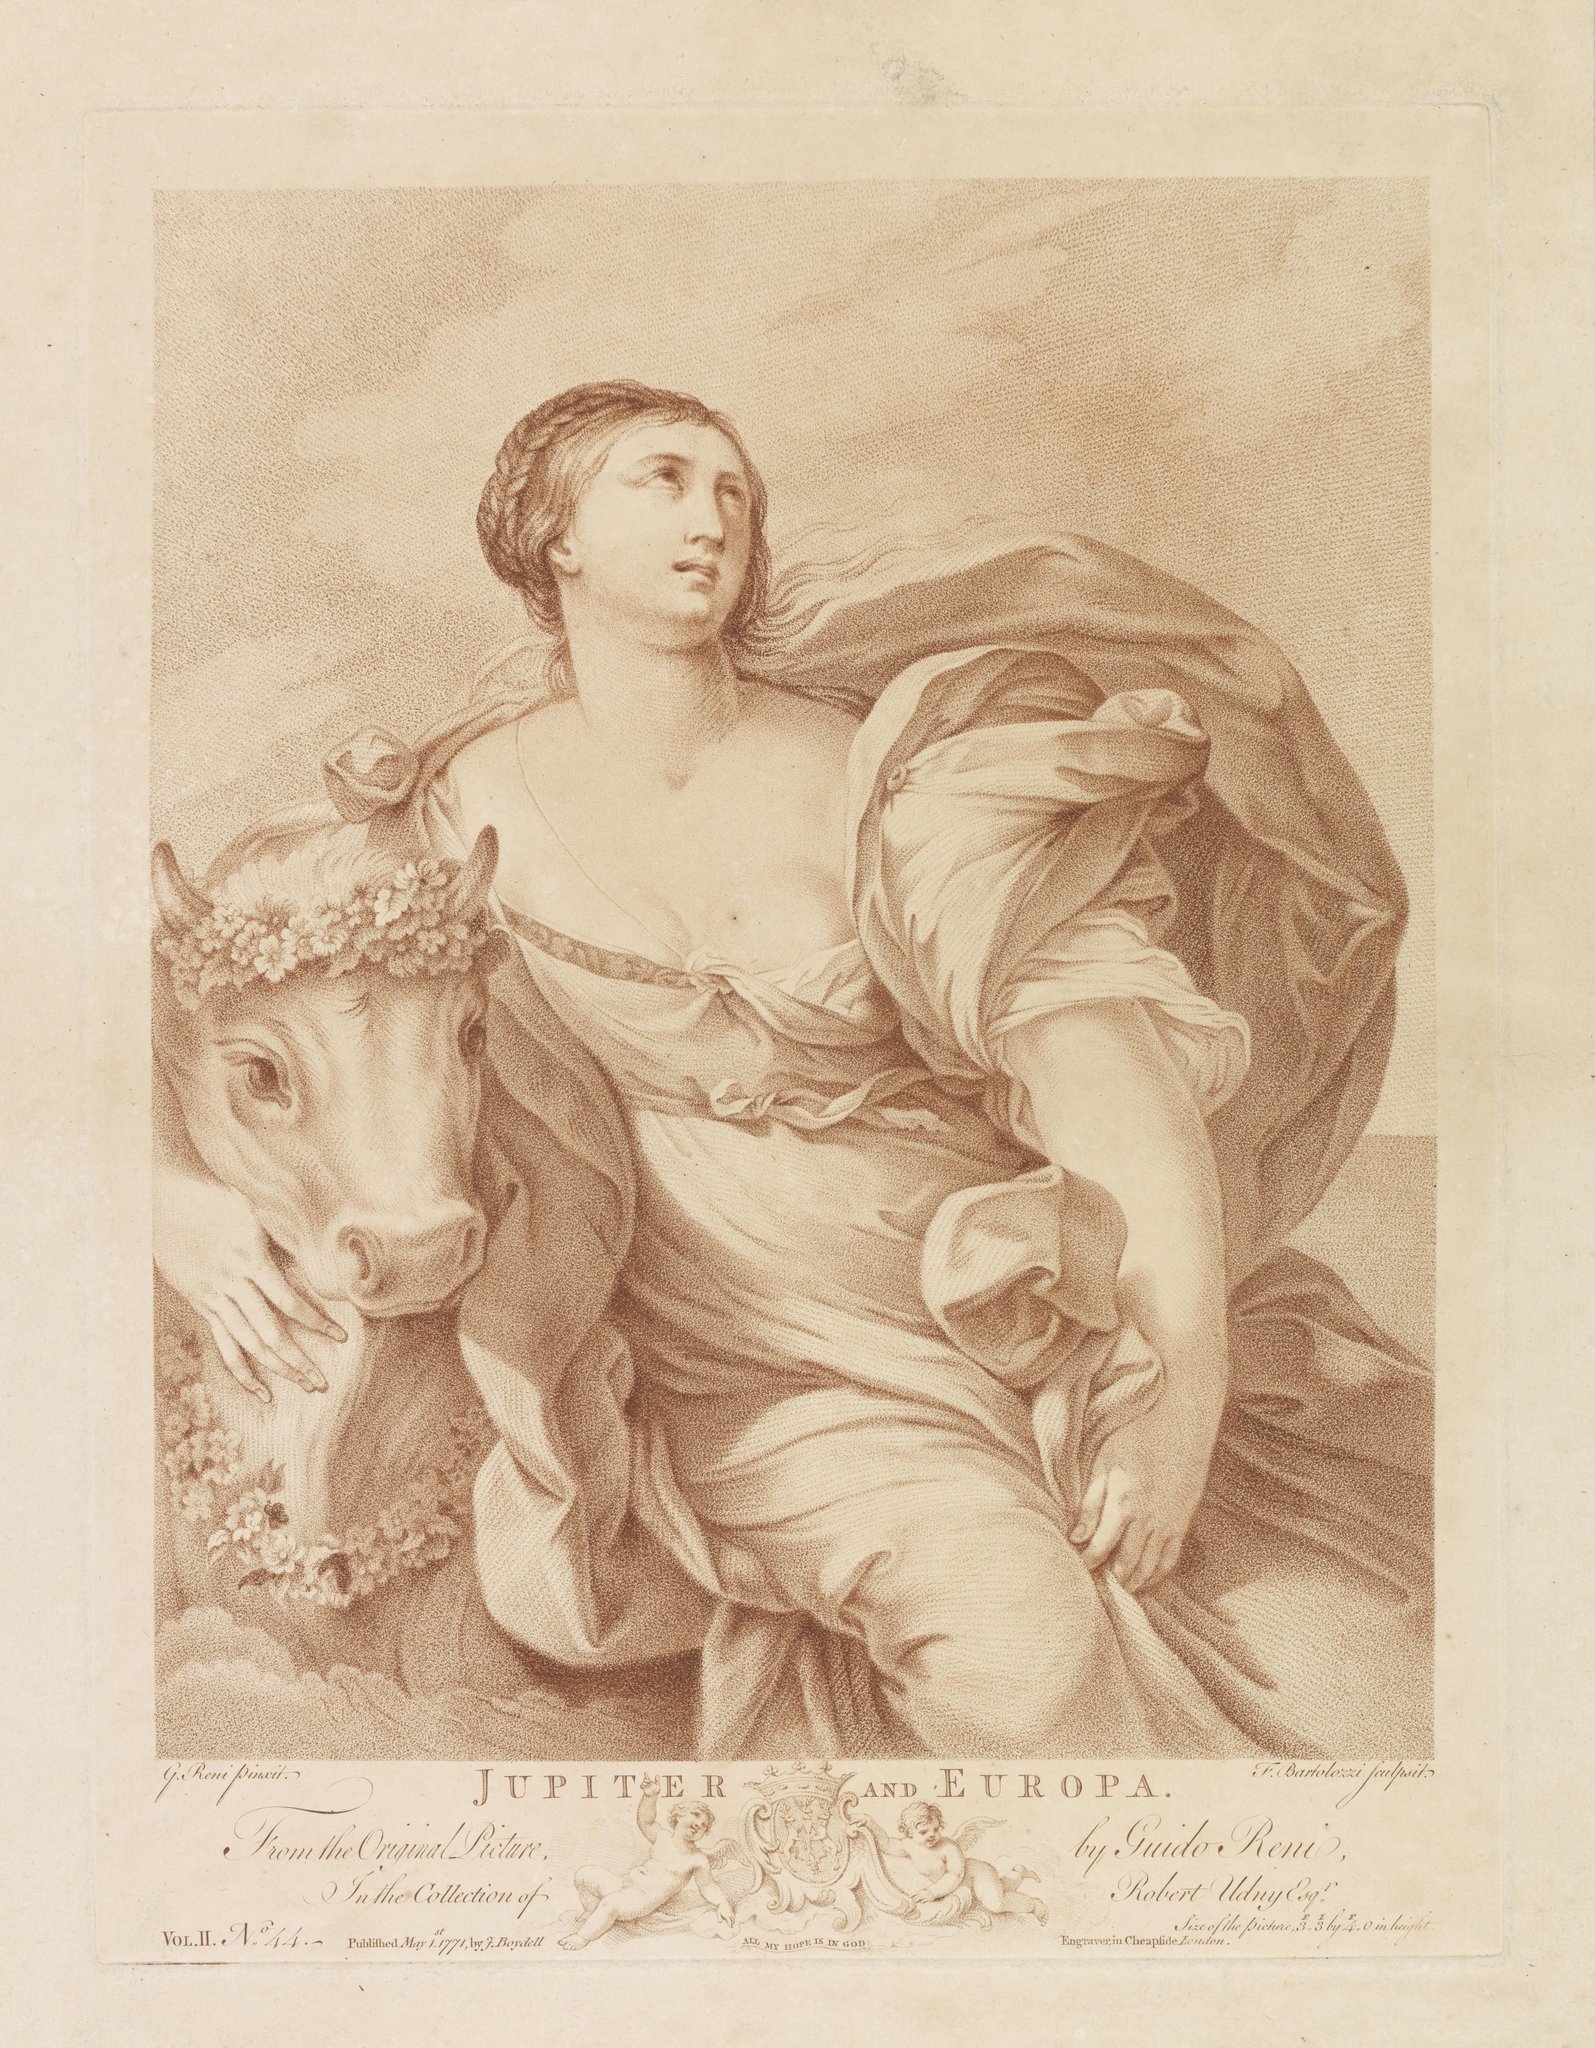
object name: print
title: Jupiter en Europa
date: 1771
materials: paper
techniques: etching, engraving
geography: italy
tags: jupiter, usually in the shape of a white bull, abducts europa and carries her across the water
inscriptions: collector's mark: Lugt 2228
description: Jupiter in de gedaante van een stier met Europa op zijn rug. In de ondermarge tekst in het Engels en een schild geflankeerd door twee putti. Genummerd linksonder: Vol. II, No. 44.